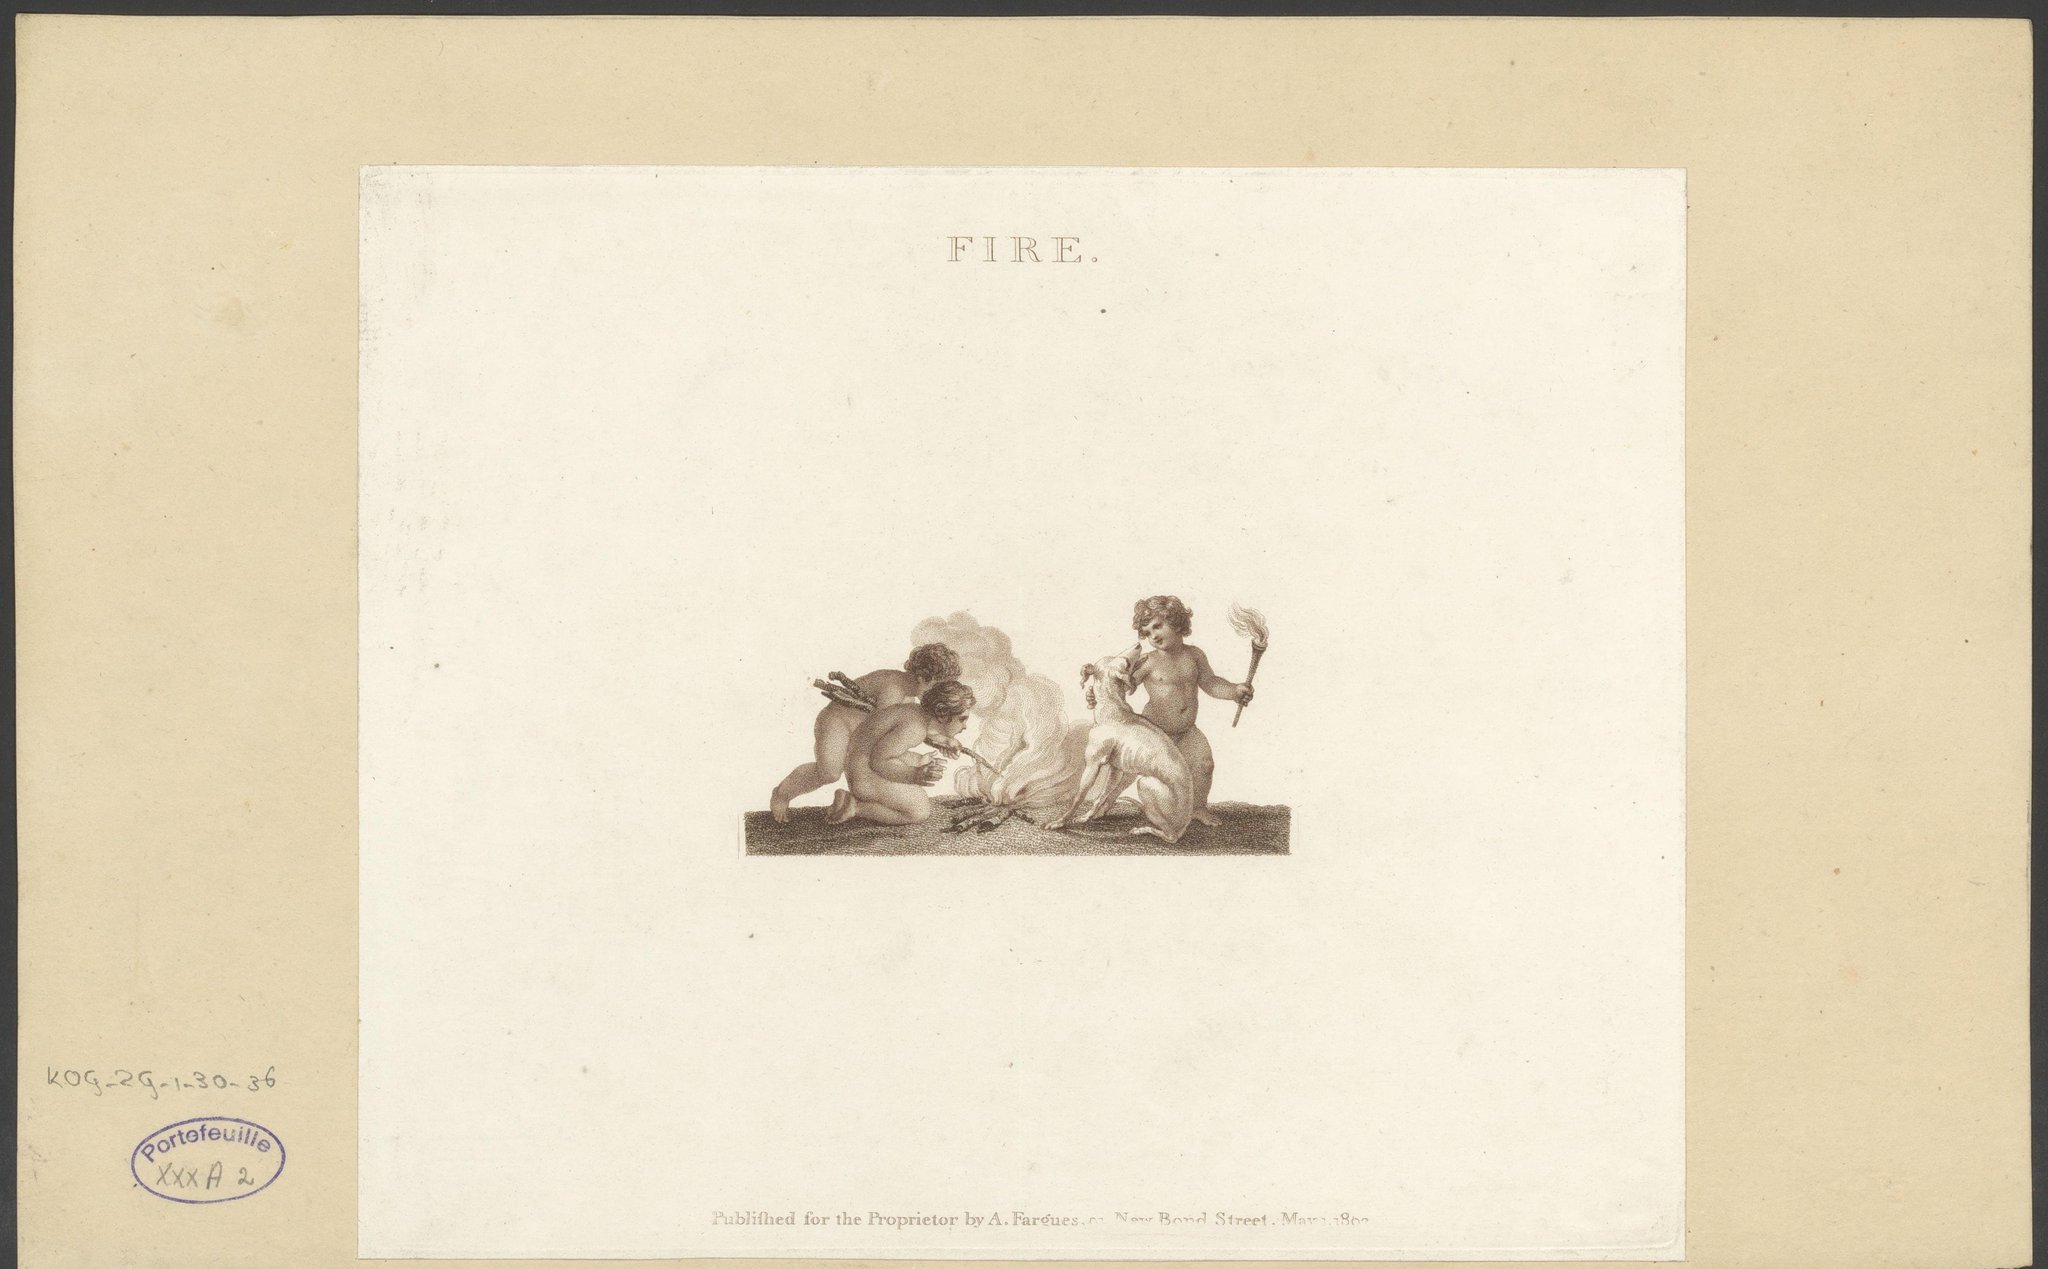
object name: print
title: Fire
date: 1802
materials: paper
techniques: etching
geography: amsterdam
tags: fire (one of the four elements), cupids: 'amores', 'amoretti', 'putti', dog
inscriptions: stamp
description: Drie putti beelden het element vuur uit met een vuur, een toorts en een hond. Onderwerpsrubrieken binnen de Atlas Zeden en Gewoonten: Zeden en Gewoonten in engeren zin. Volksleven. Zinnebeeldige voorstellingen uit het volkleven op serieprenten. Elementen.